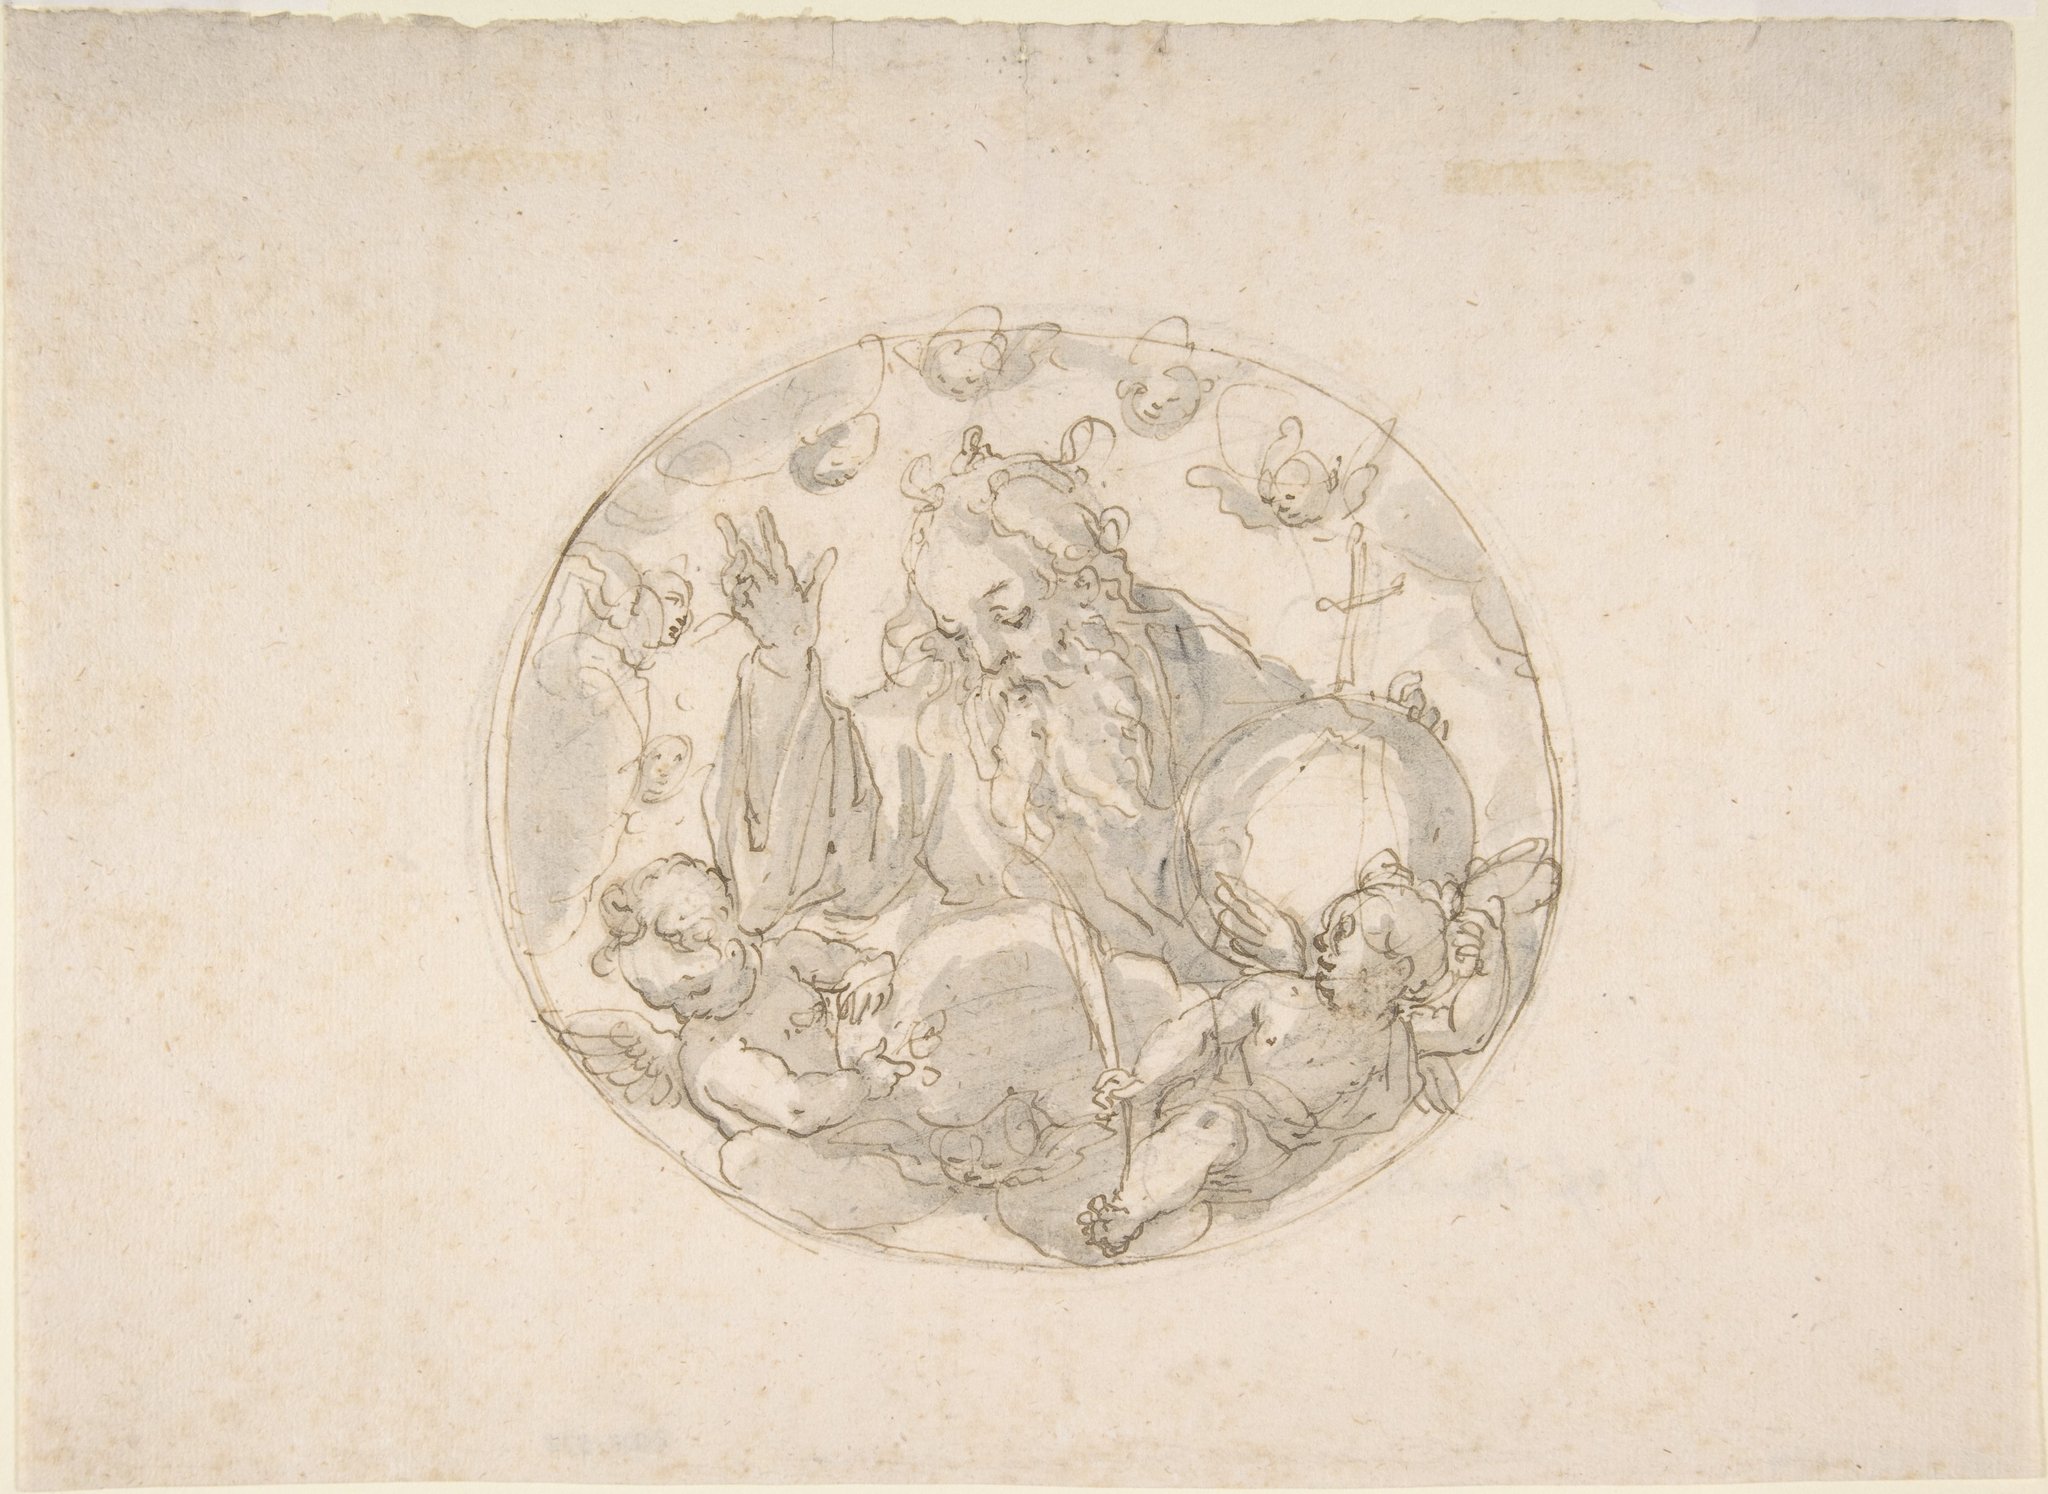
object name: drawing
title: God the Father with the Globe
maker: hans krumpper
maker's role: artist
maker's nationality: german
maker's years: 1570-1643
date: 1567-1666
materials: ink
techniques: pen, wash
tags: globes,god the father